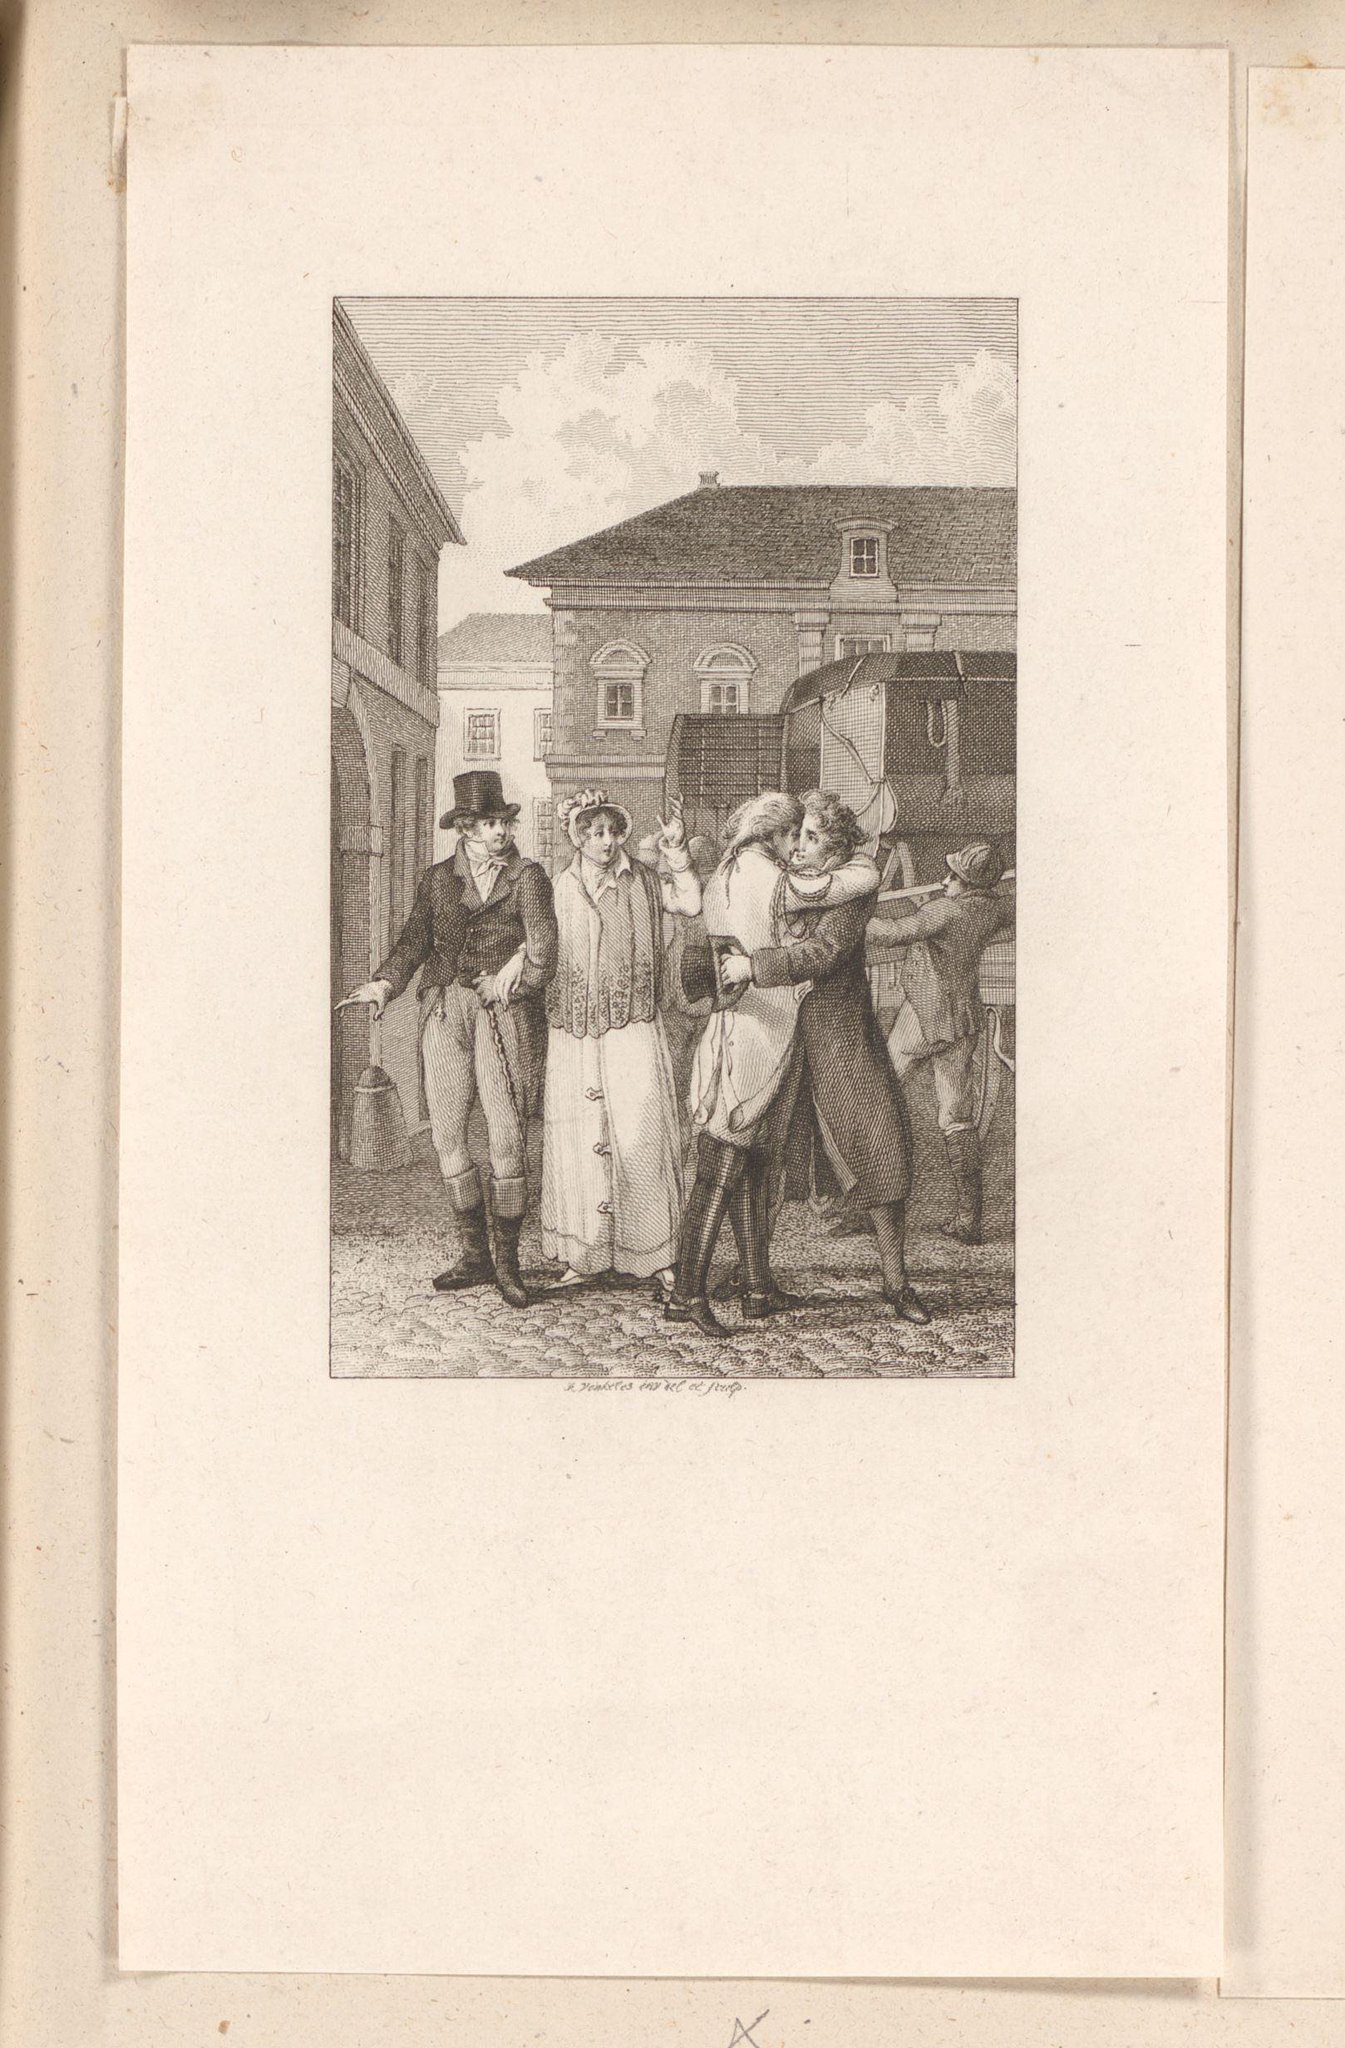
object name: print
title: Reinoud Jan van Golstein verwelkomt zijn vriend Linzthal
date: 1809-1810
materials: paper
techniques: engraving, etching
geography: amsterdam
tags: embracing each other, kissing, being welcomed ~ travelling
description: Reinoud Jan van Golstein verwelkomt zijn boezemvriend Karel Linzthal die per koets is aangekomen. Links de zuster van Linzthal, Emilia, en een onbekende heer. De prent maakt deel uit van een album.